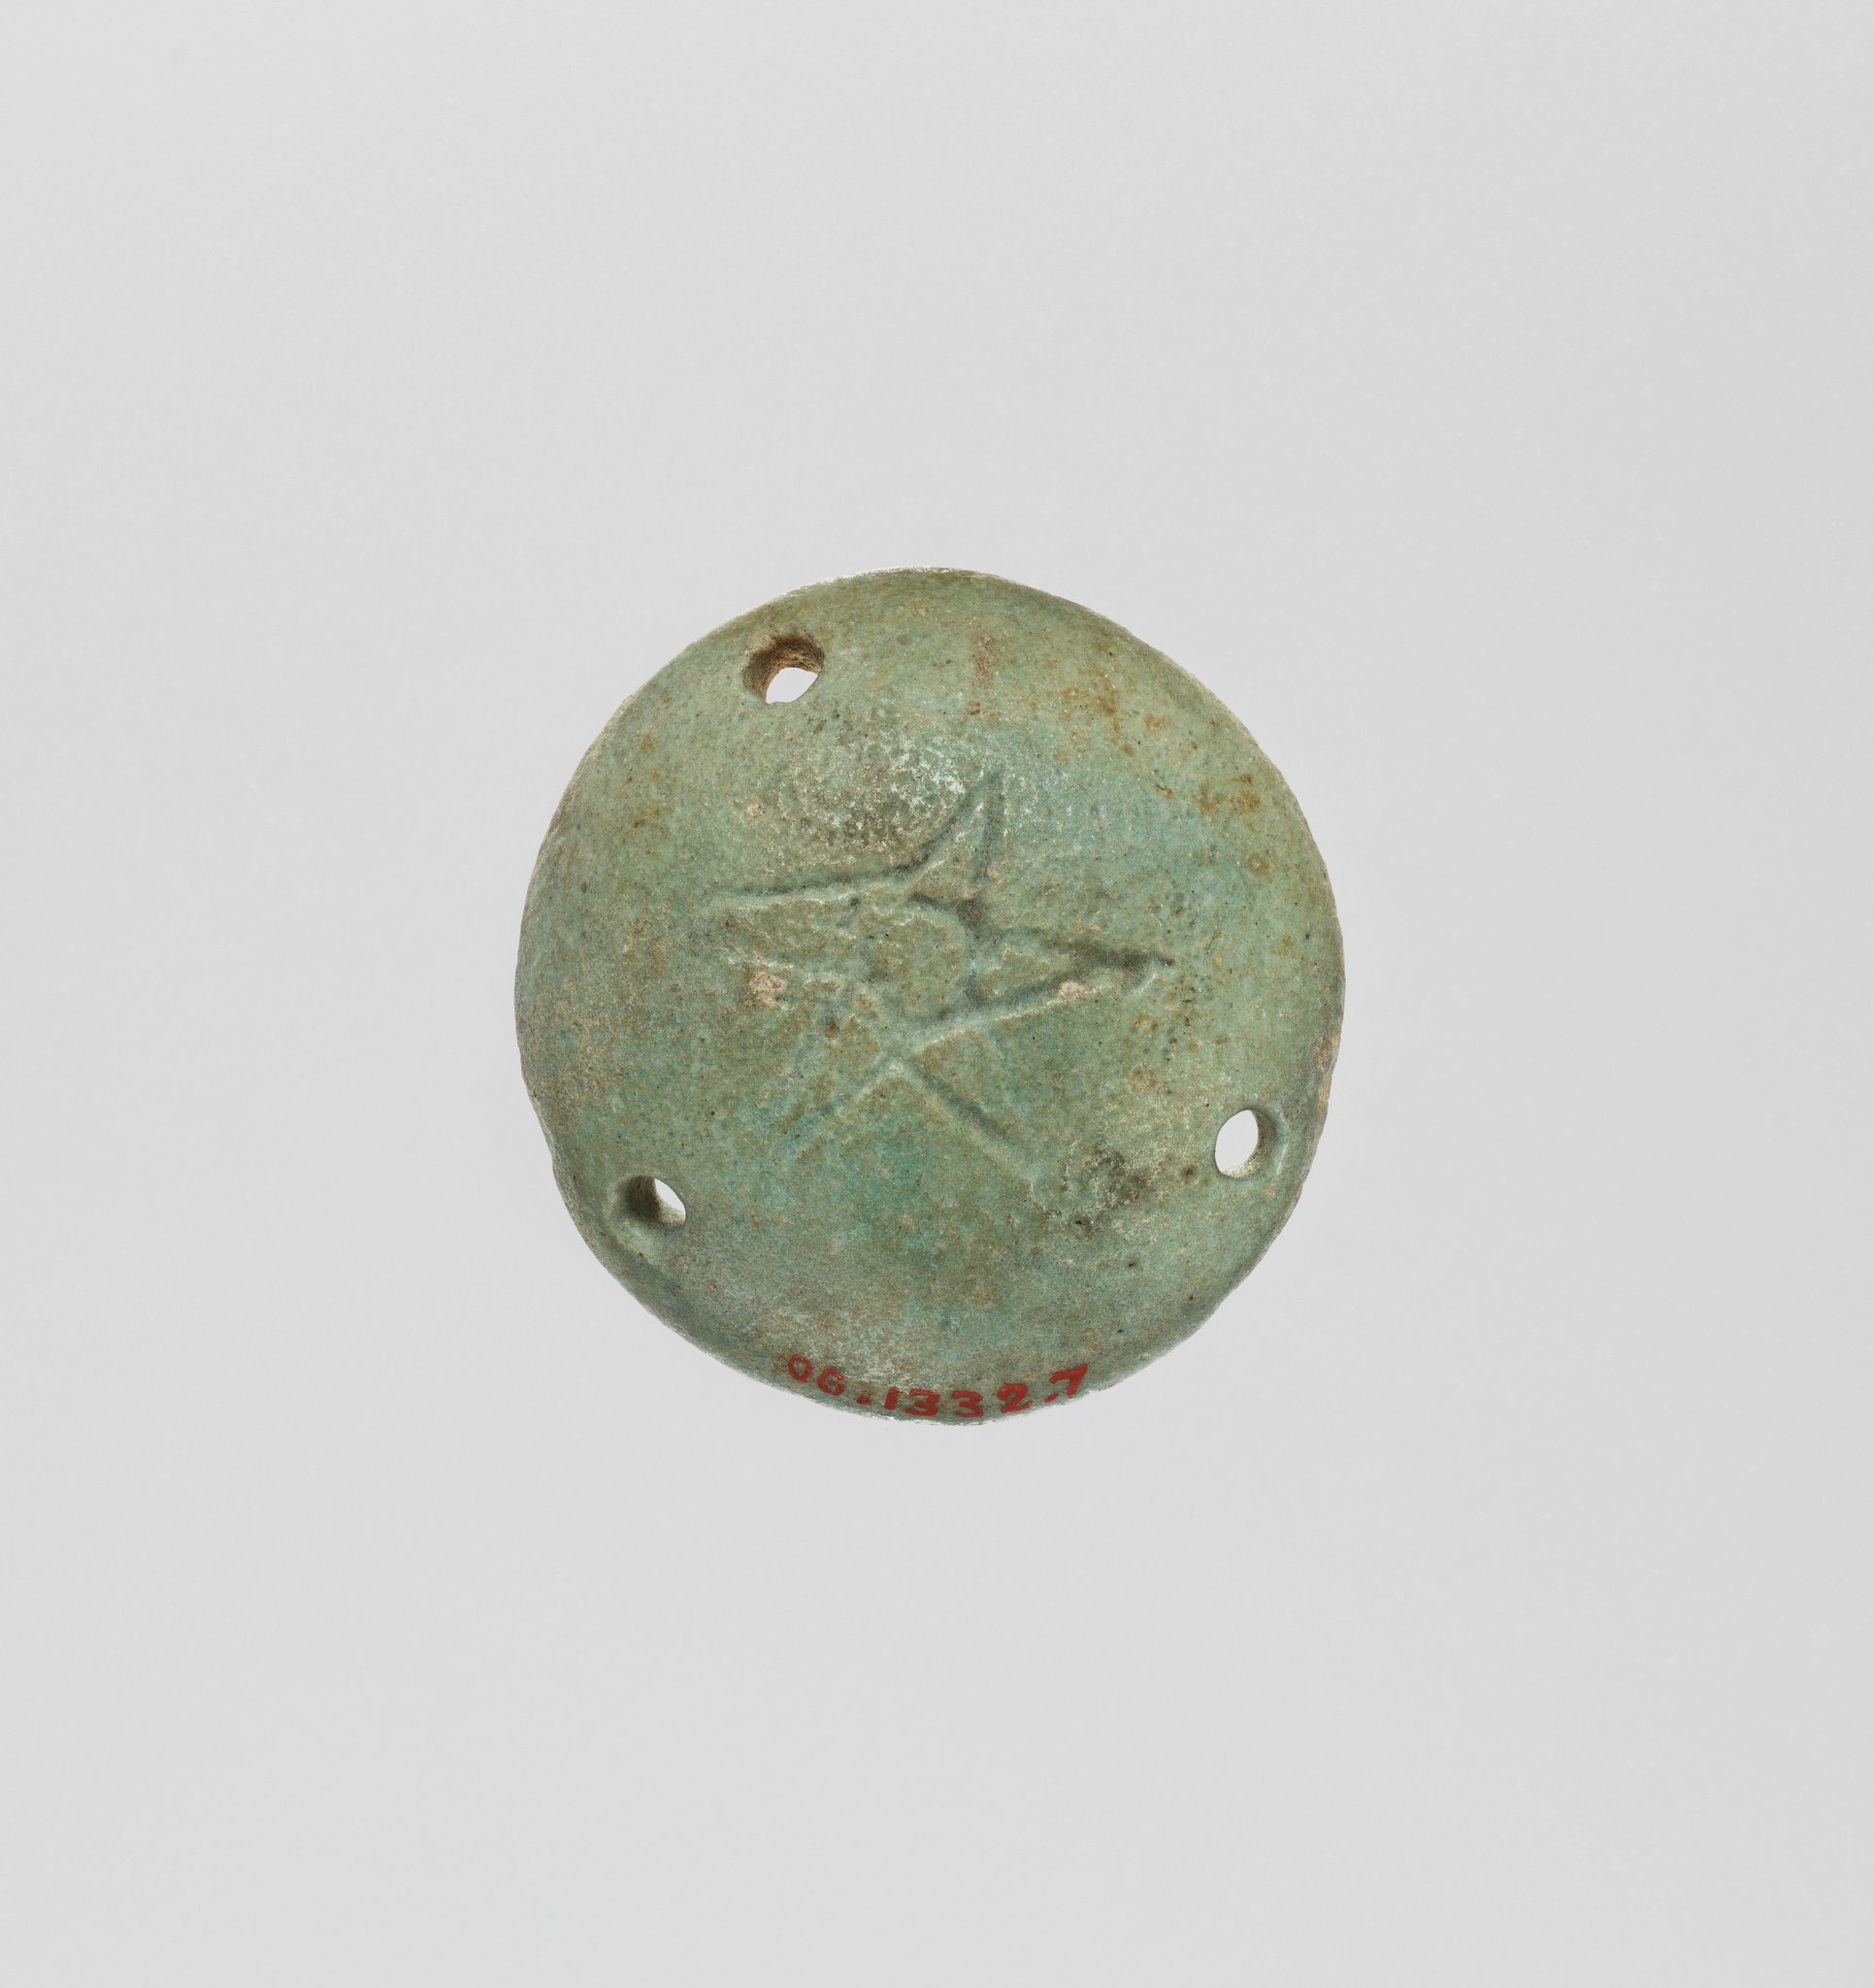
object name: disk inscribed with five pointed star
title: Disk inscribed with five-pointed star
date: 664-332 BCE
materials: faience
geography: egypt